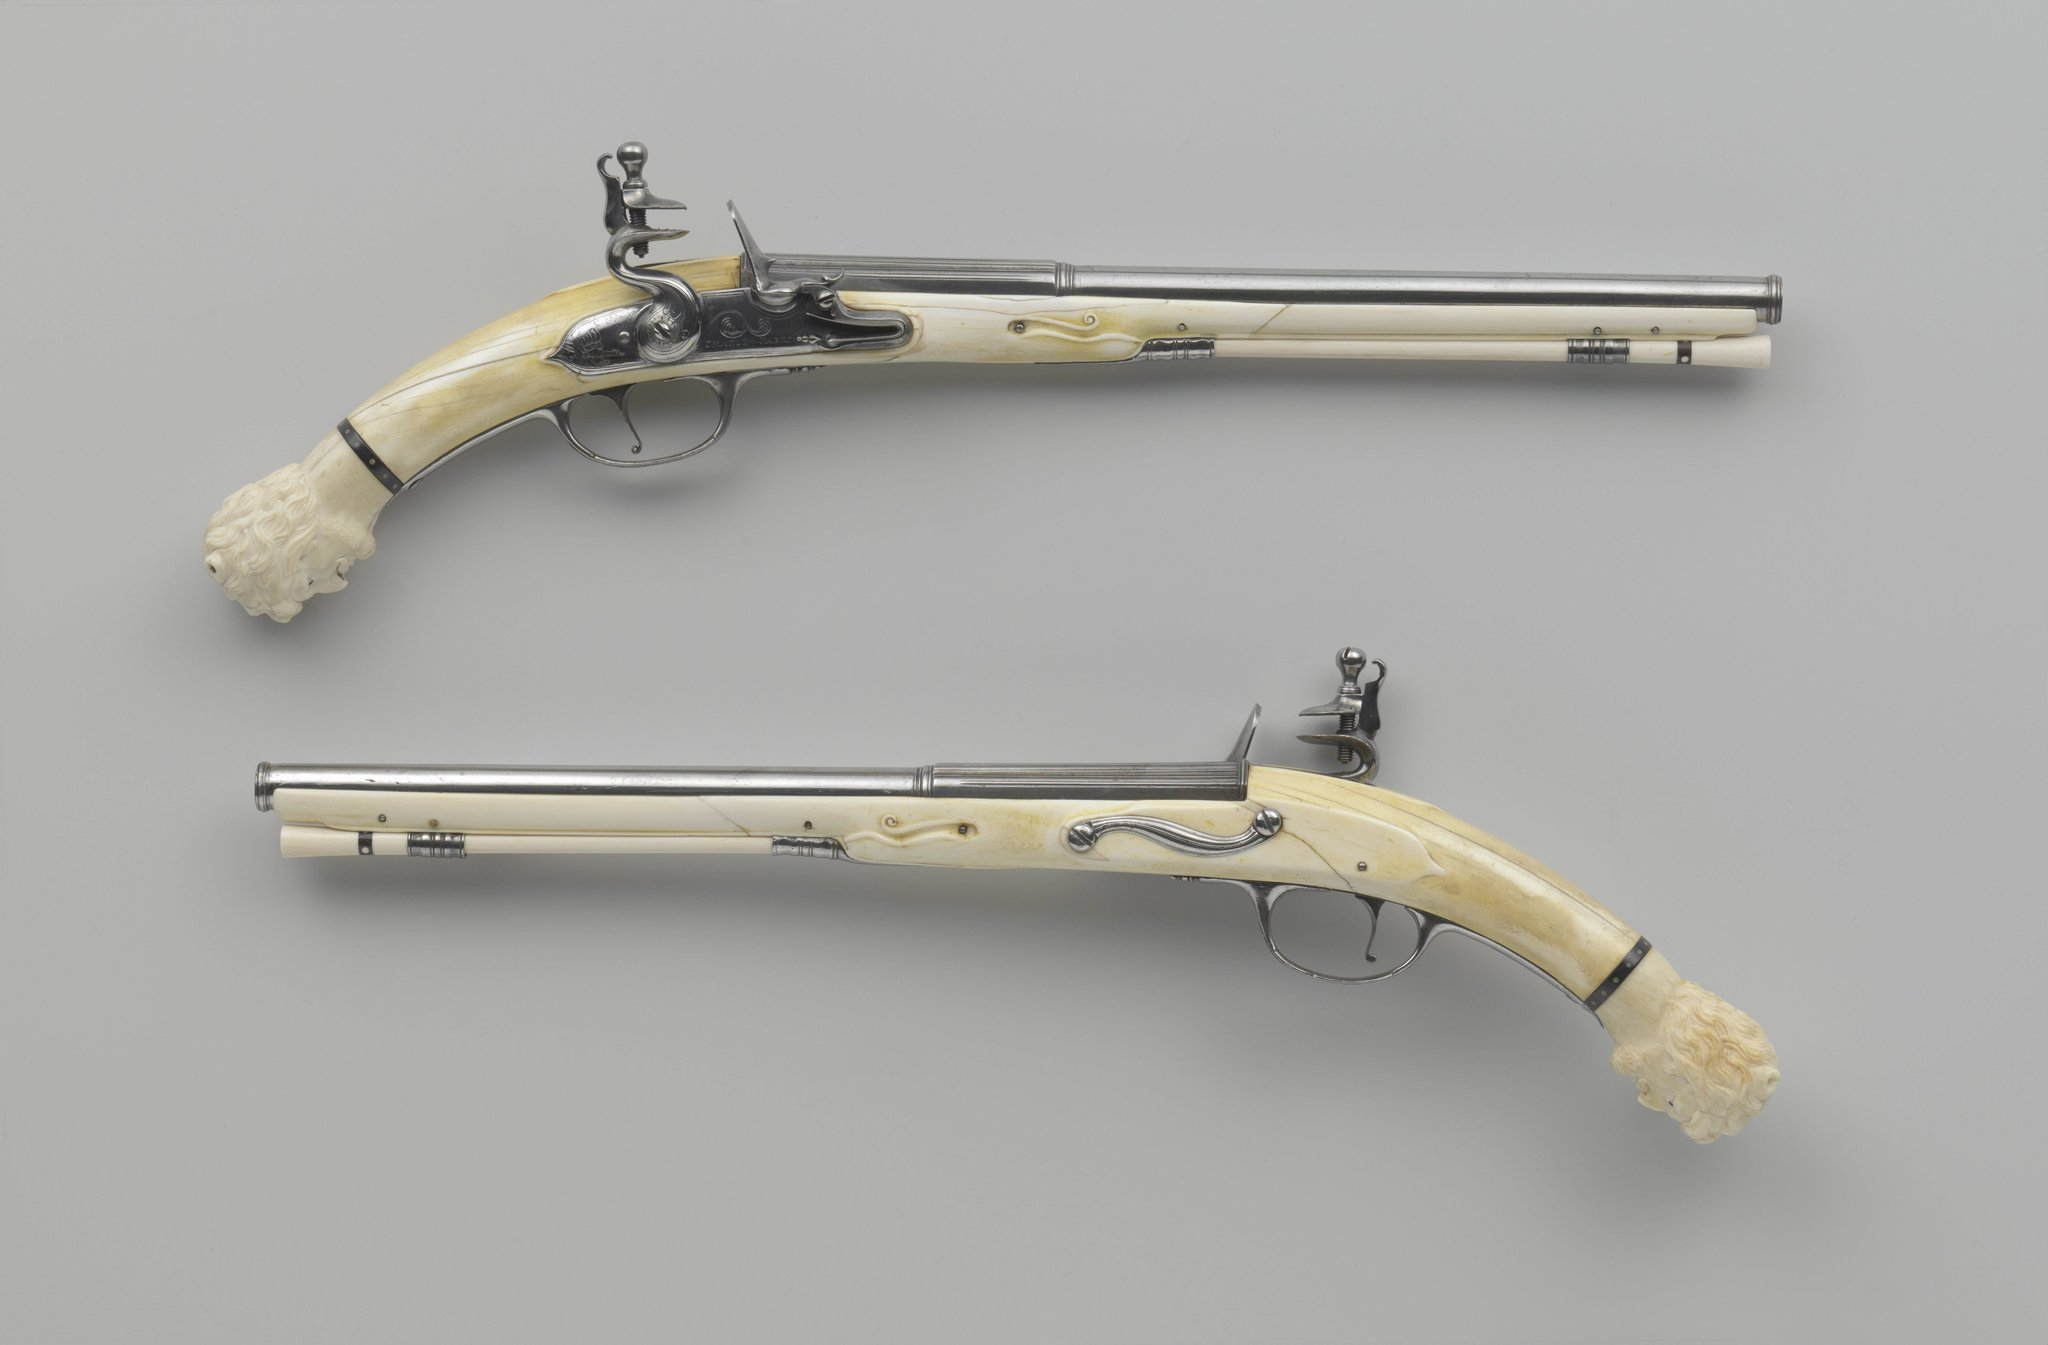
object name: flintlock pistol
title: Vuursteenpistool met ivoren lade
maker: charles fabri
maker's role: geweermaker, pistoolmaker, smid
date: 1675-1680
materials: wood, gold, iron, ivory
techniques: cutting, encrustation, engraving, inlay, striking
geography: maastricht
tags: (story of) hercules (heracles)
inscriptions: inscription: ‘GMA’, signature: ‘CHARLE*FABRI’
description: Deel van een koppel. Het aan de binnenkant geblauwde slot is versierd met een enkele rank, een vogel op een tak en een signatuur op de slotplaat. Op de loop staan de met goud geïncrusteerde letters GMA. De massief ivoren kolf is in reliëf gesneden en eindigt na een band van met ivoor ingelegd ebbenhout in de rondom gesneden kolfknop in de vorm van het bebaarde hoofd van Hercules met de kop van de Nemeïsche leeuw als helm. Het ijzeren beslag bestaat onder meer uit een ivoren laadstok waarvan de kop afgescheiden is door een ebbenhouten band zoals tussen de greep en de kolfknop zit.